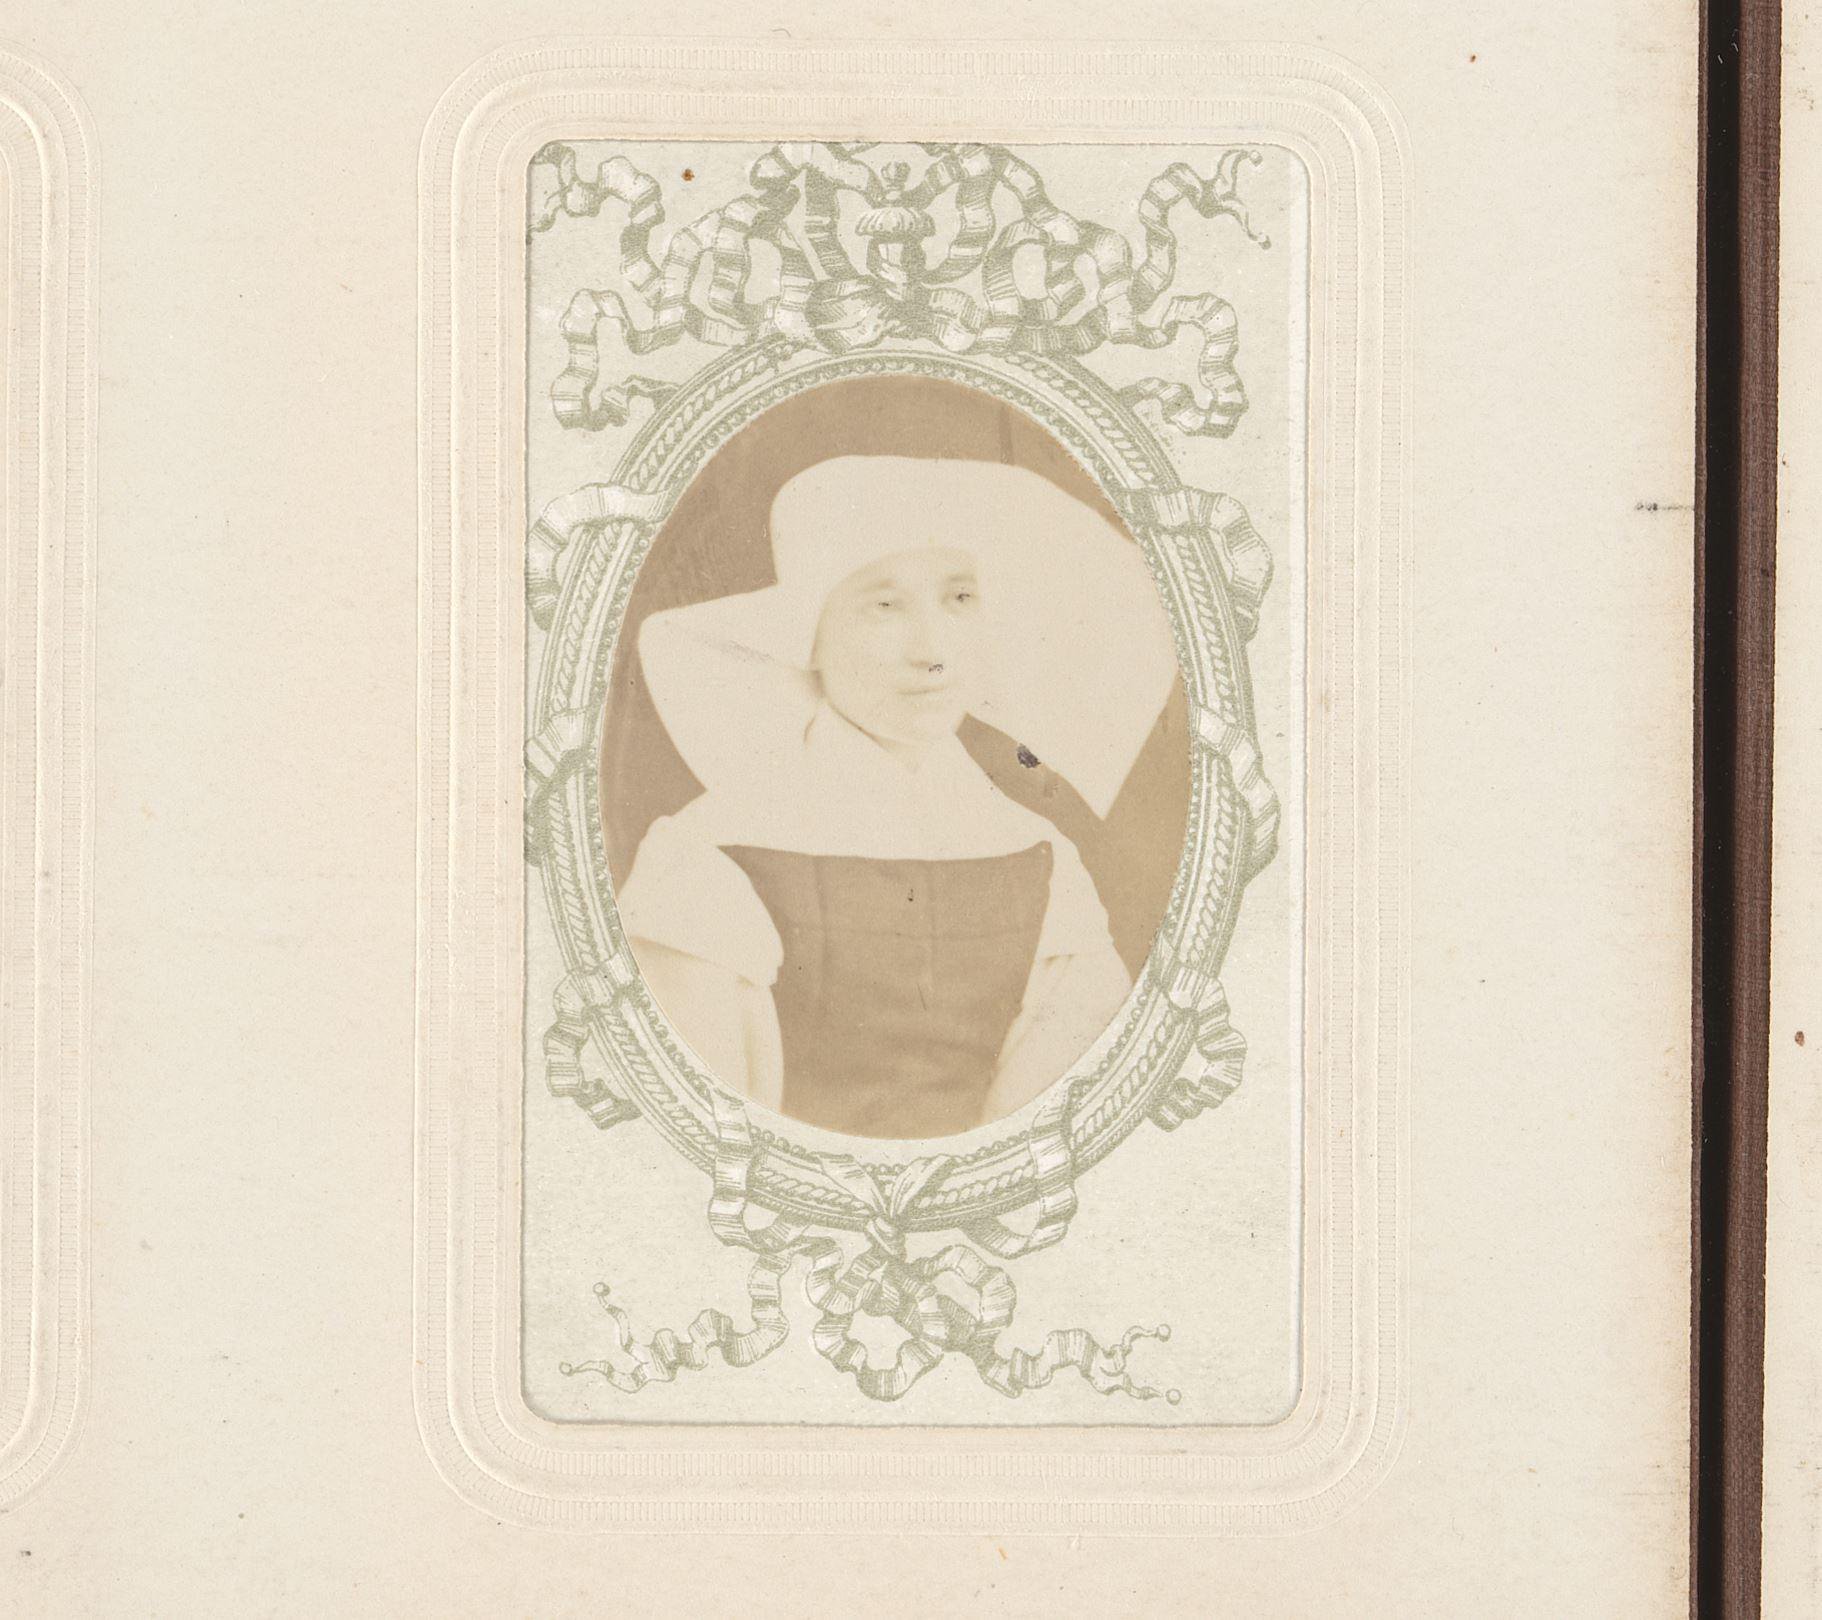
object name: carte de visite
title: Portret van een vrouw met een witte kap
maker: Anonymous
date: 1865-1900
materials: cardboard, paper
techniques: albumen print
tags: historical persons - bb - woman, folk costume, regional costume